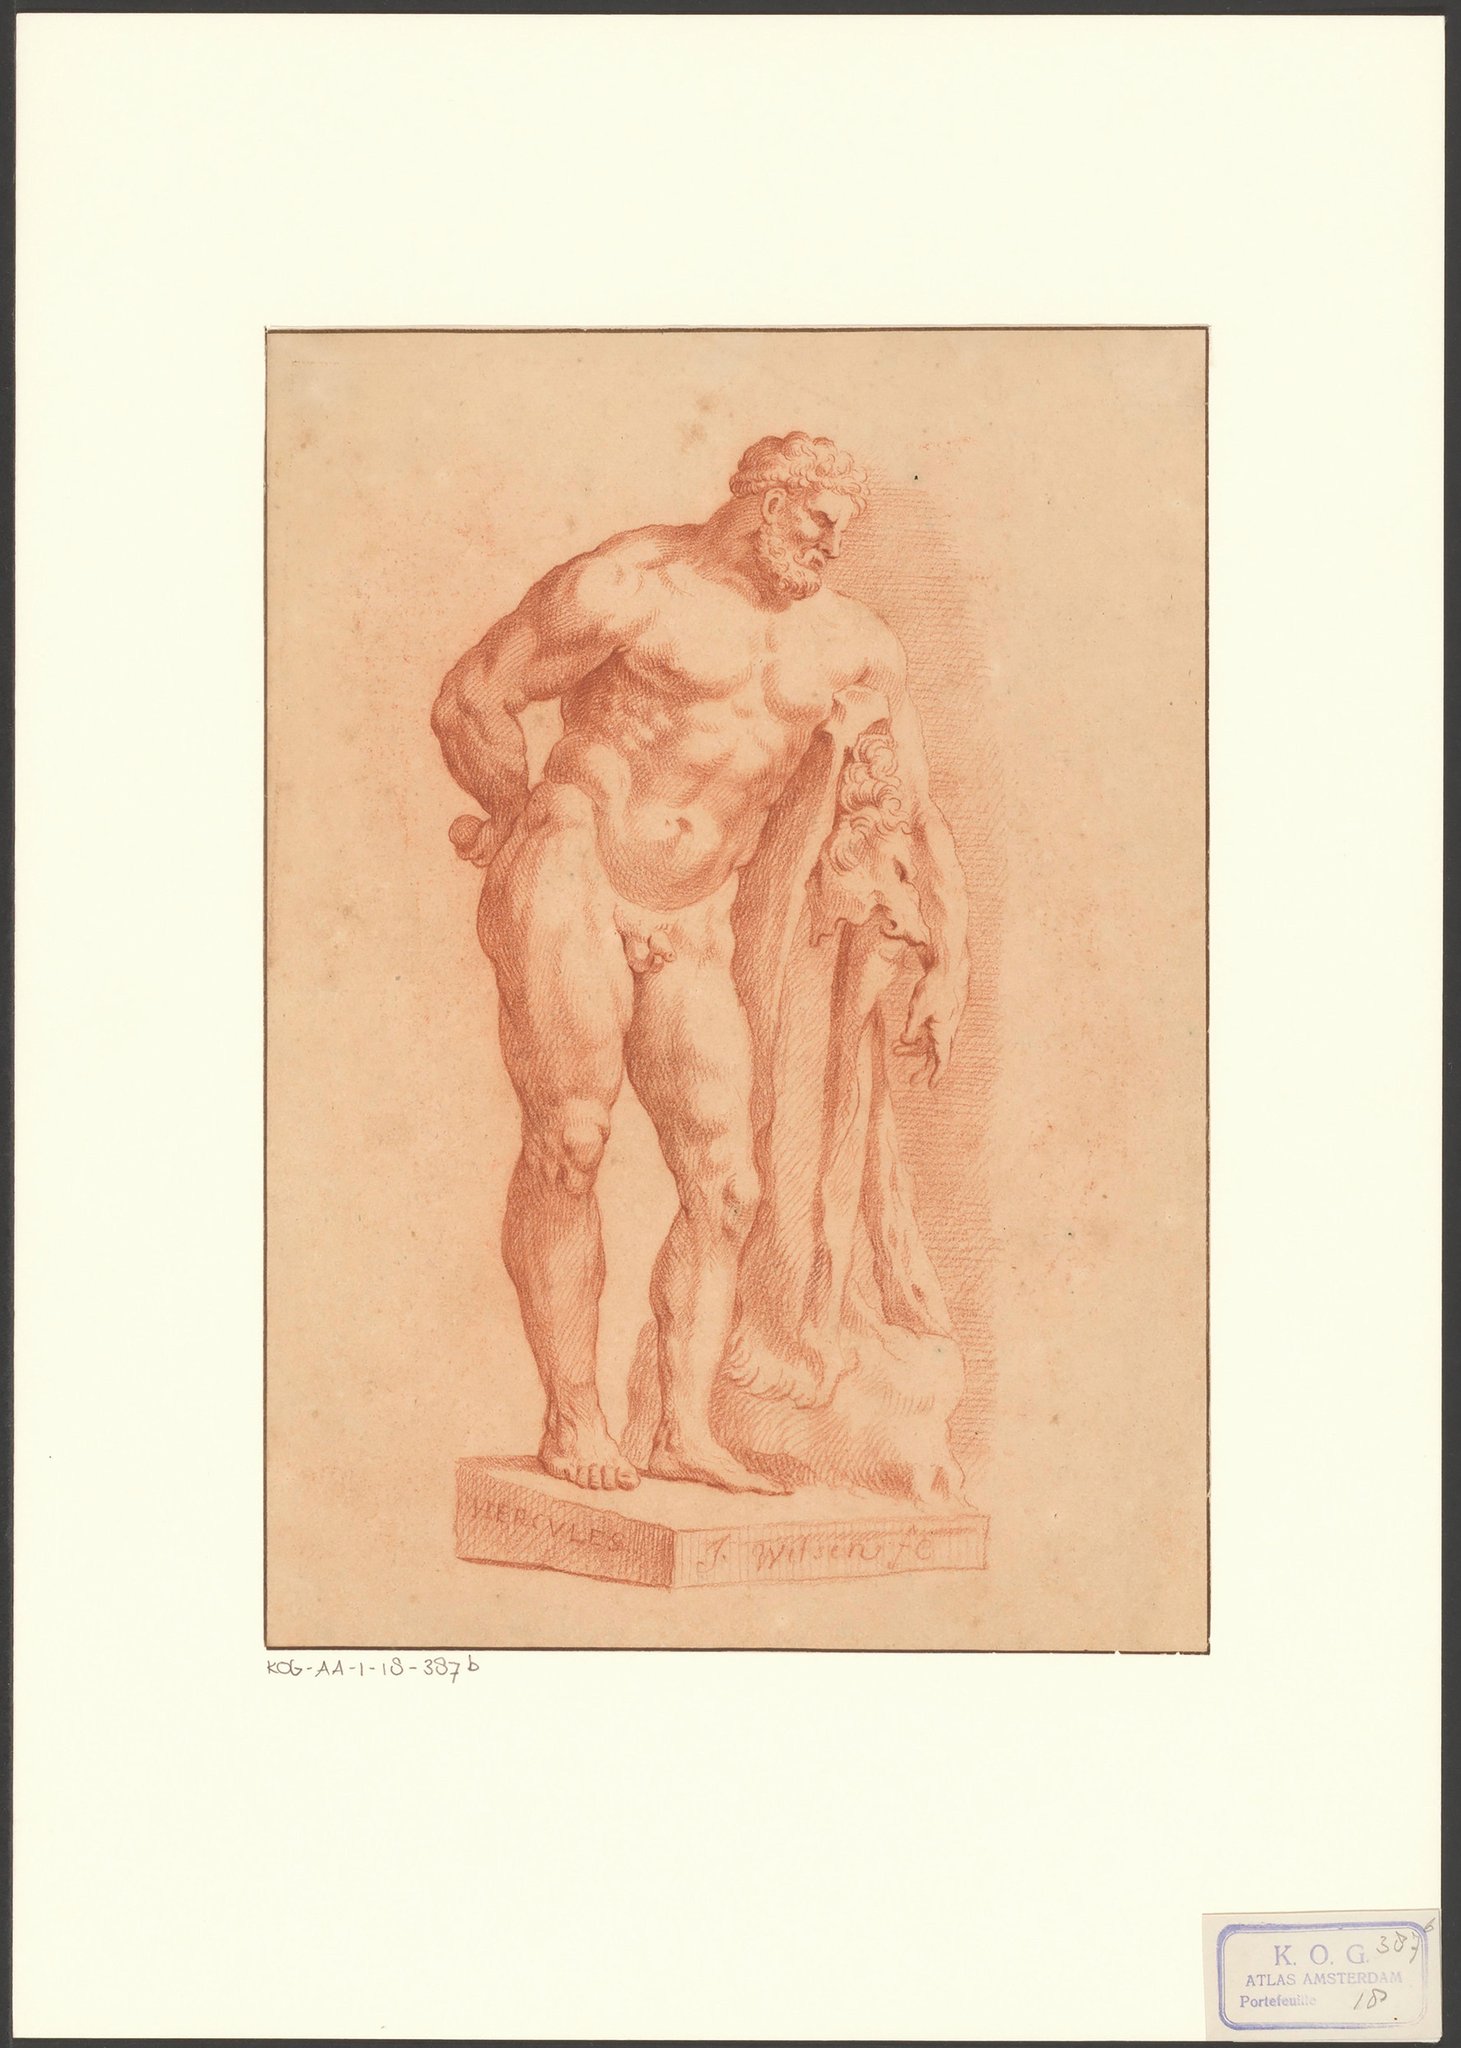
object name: drawing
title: Hercules Farnese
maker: jonas witsen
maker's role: mayor, print maker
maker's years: 1705-1767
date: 1715-1767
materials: chalk, paper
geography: amsterdam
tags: (story of) hercules (heracles), sculpture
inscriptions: inscription: ‘Port. 18-387b’, collector's mark: ‘18’ Lugt 1641b, signature: ‘Hercules / J. Witsen fc’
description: Onderwerpsrubriek binnen de Atlas Amsterdam: Herinneringen aan regeringsleden en hunne huisgezinnen. [voor 1800].